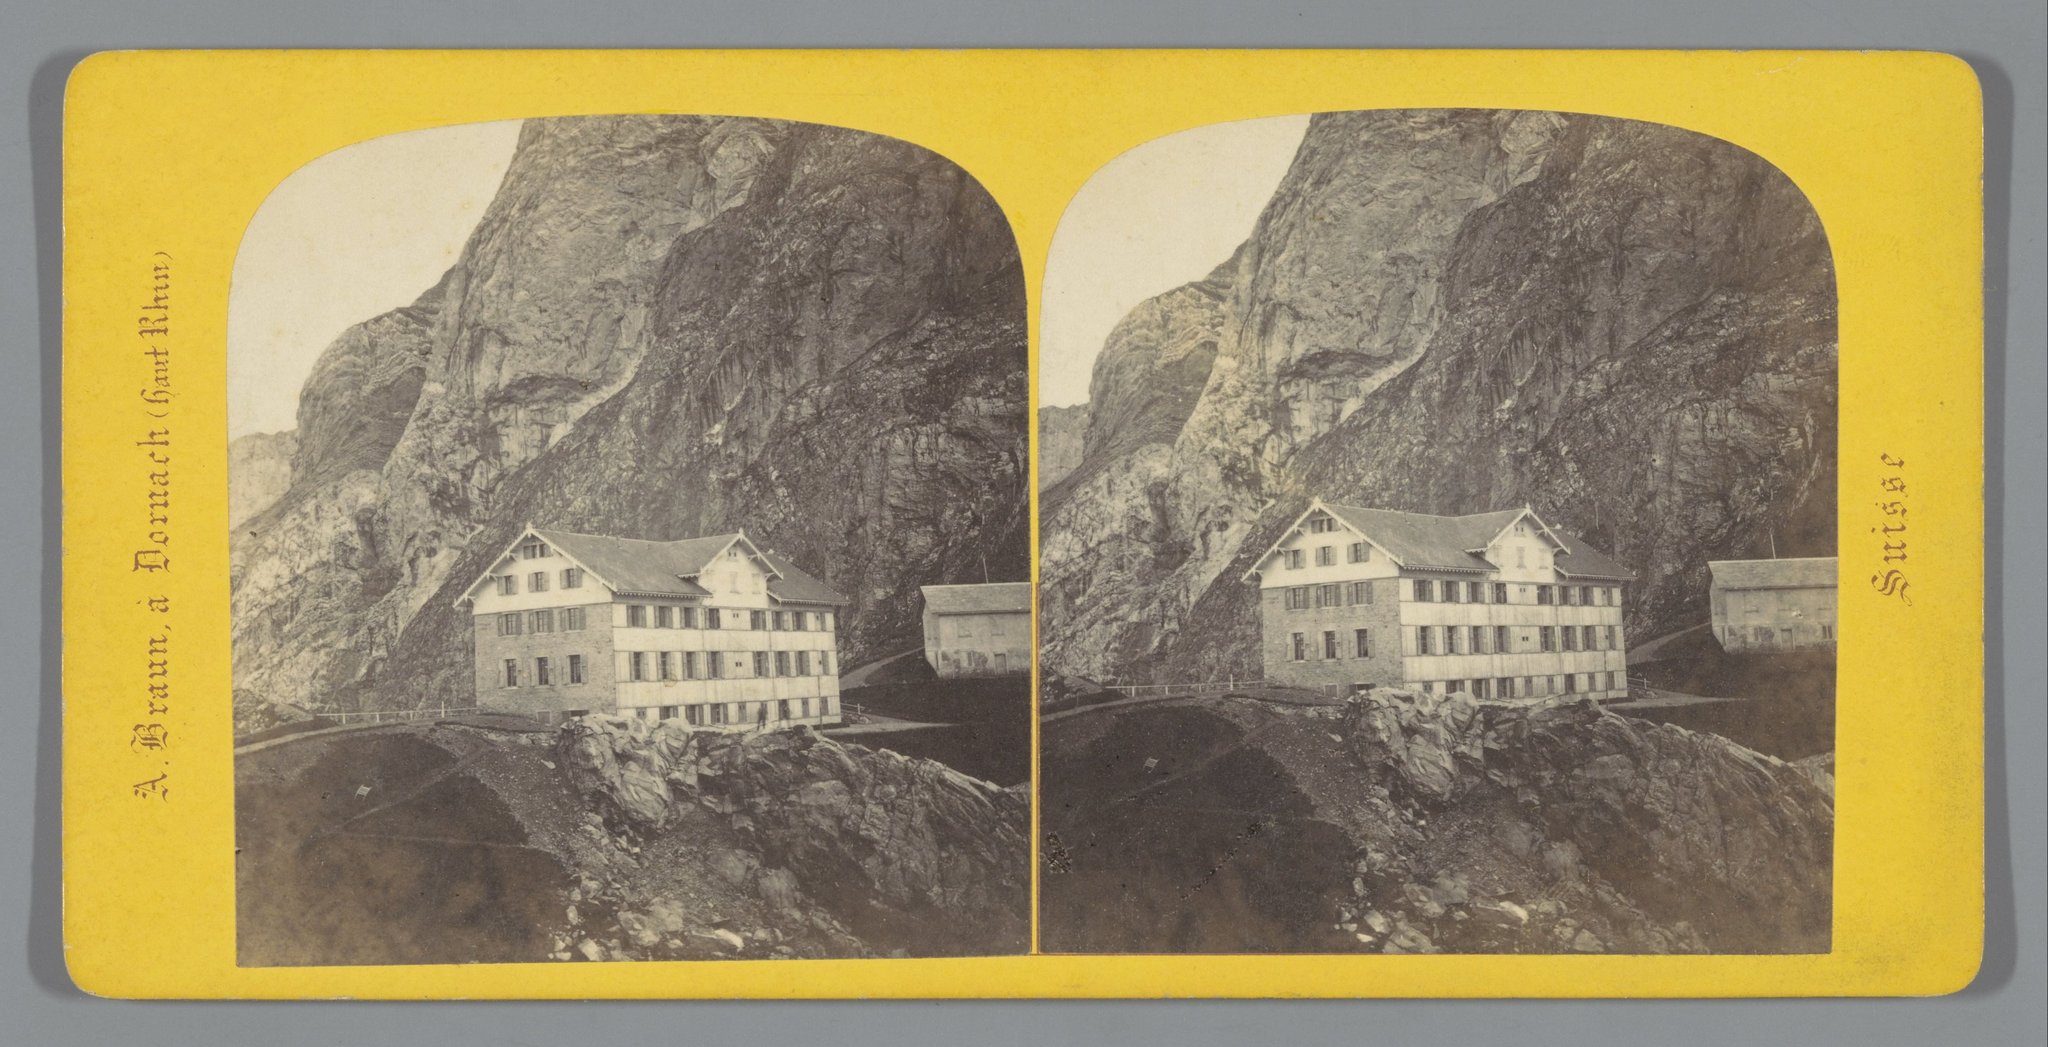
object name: stereograph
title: Hôtel Klimsenhorn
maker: Anonymous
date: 1879-1889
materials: cardboard, paper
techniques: albumen print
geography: dornach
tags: hotel, hostelry, inn, mountains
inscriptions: number: ‘No 4624.’